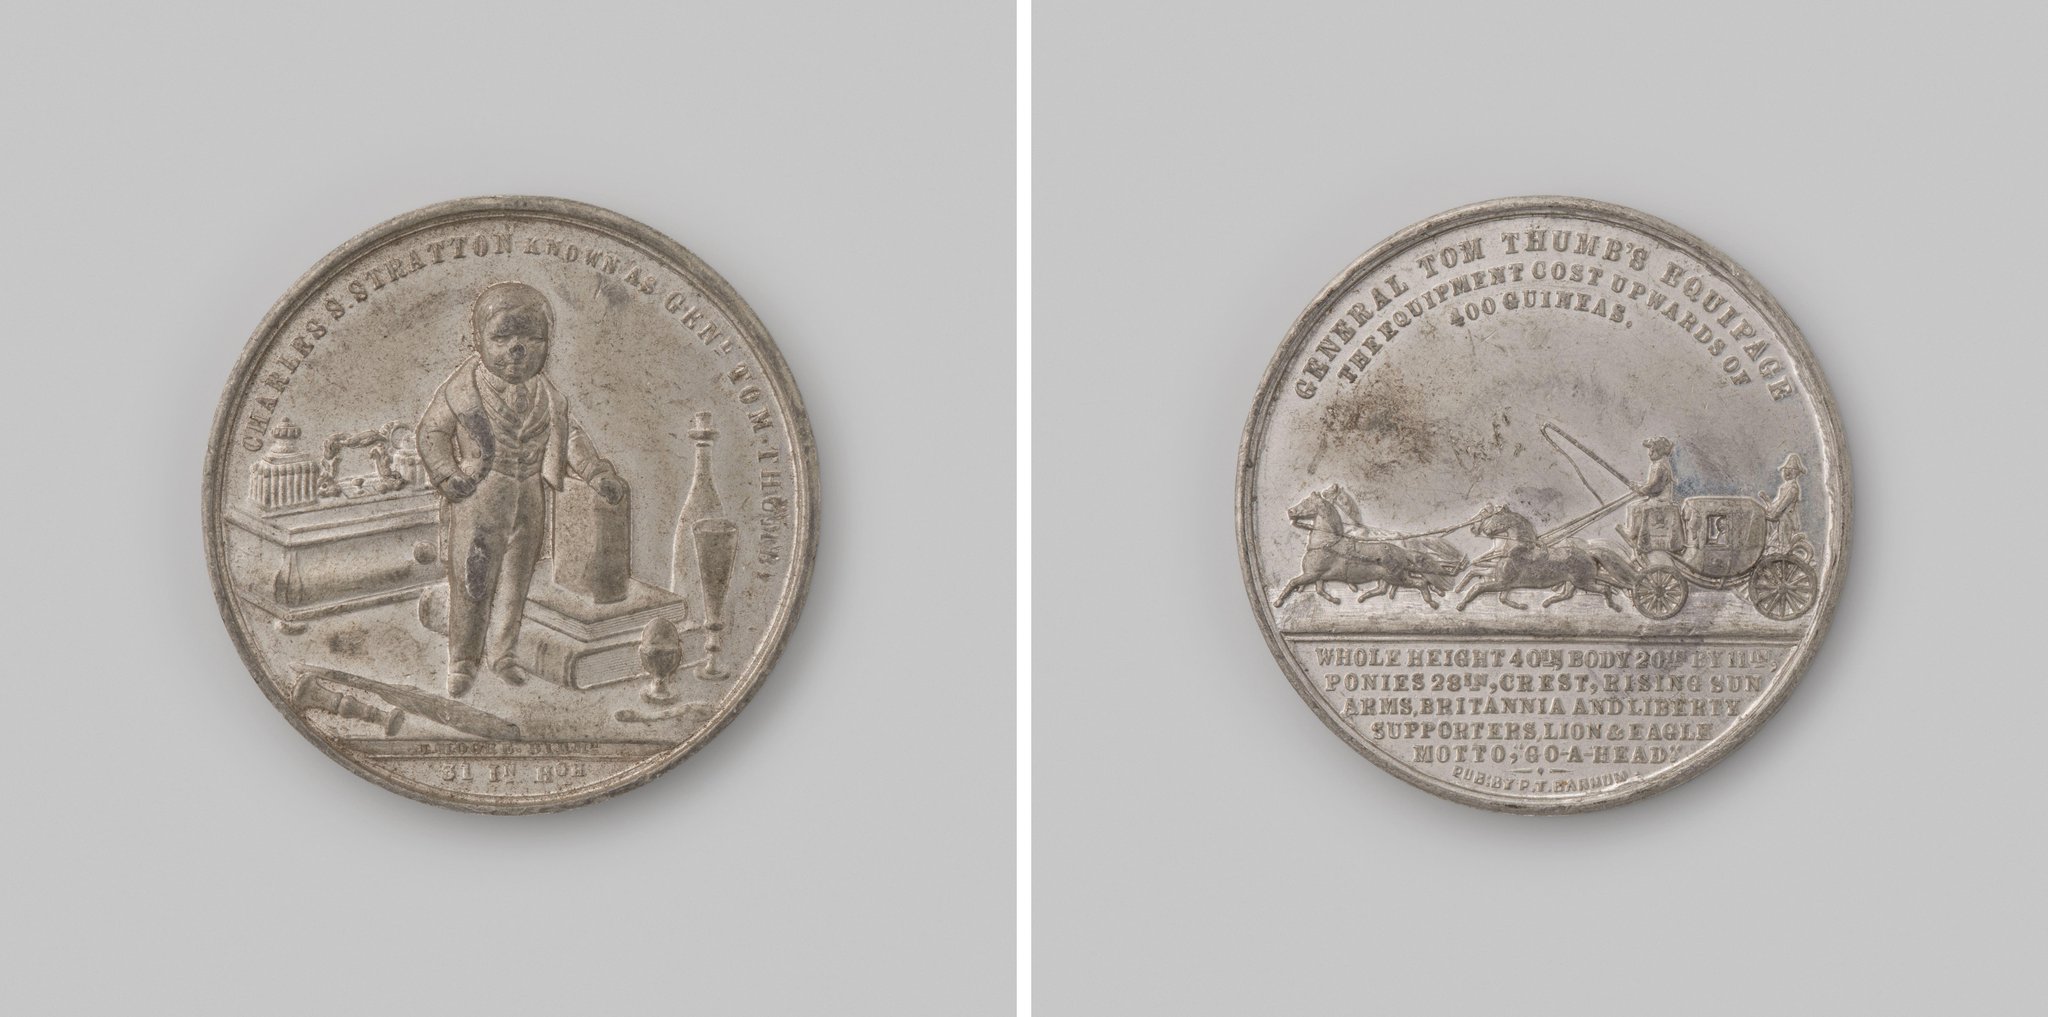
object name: history medal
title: Charles S. Stratton alias General Tom Thumb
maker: joseph moore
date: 1862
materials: tin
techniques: striking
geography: birmingham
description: Tinnen penning, op de voorzijde de kleine mens Charles Stratton (Tom Thumb) tussen bureauaccessoires, met omschrift en afsnedetekst, op de keerzijde een rijtuig met vier paarden naar links met boven drie regels omschrift en onder vijf regels tekst.